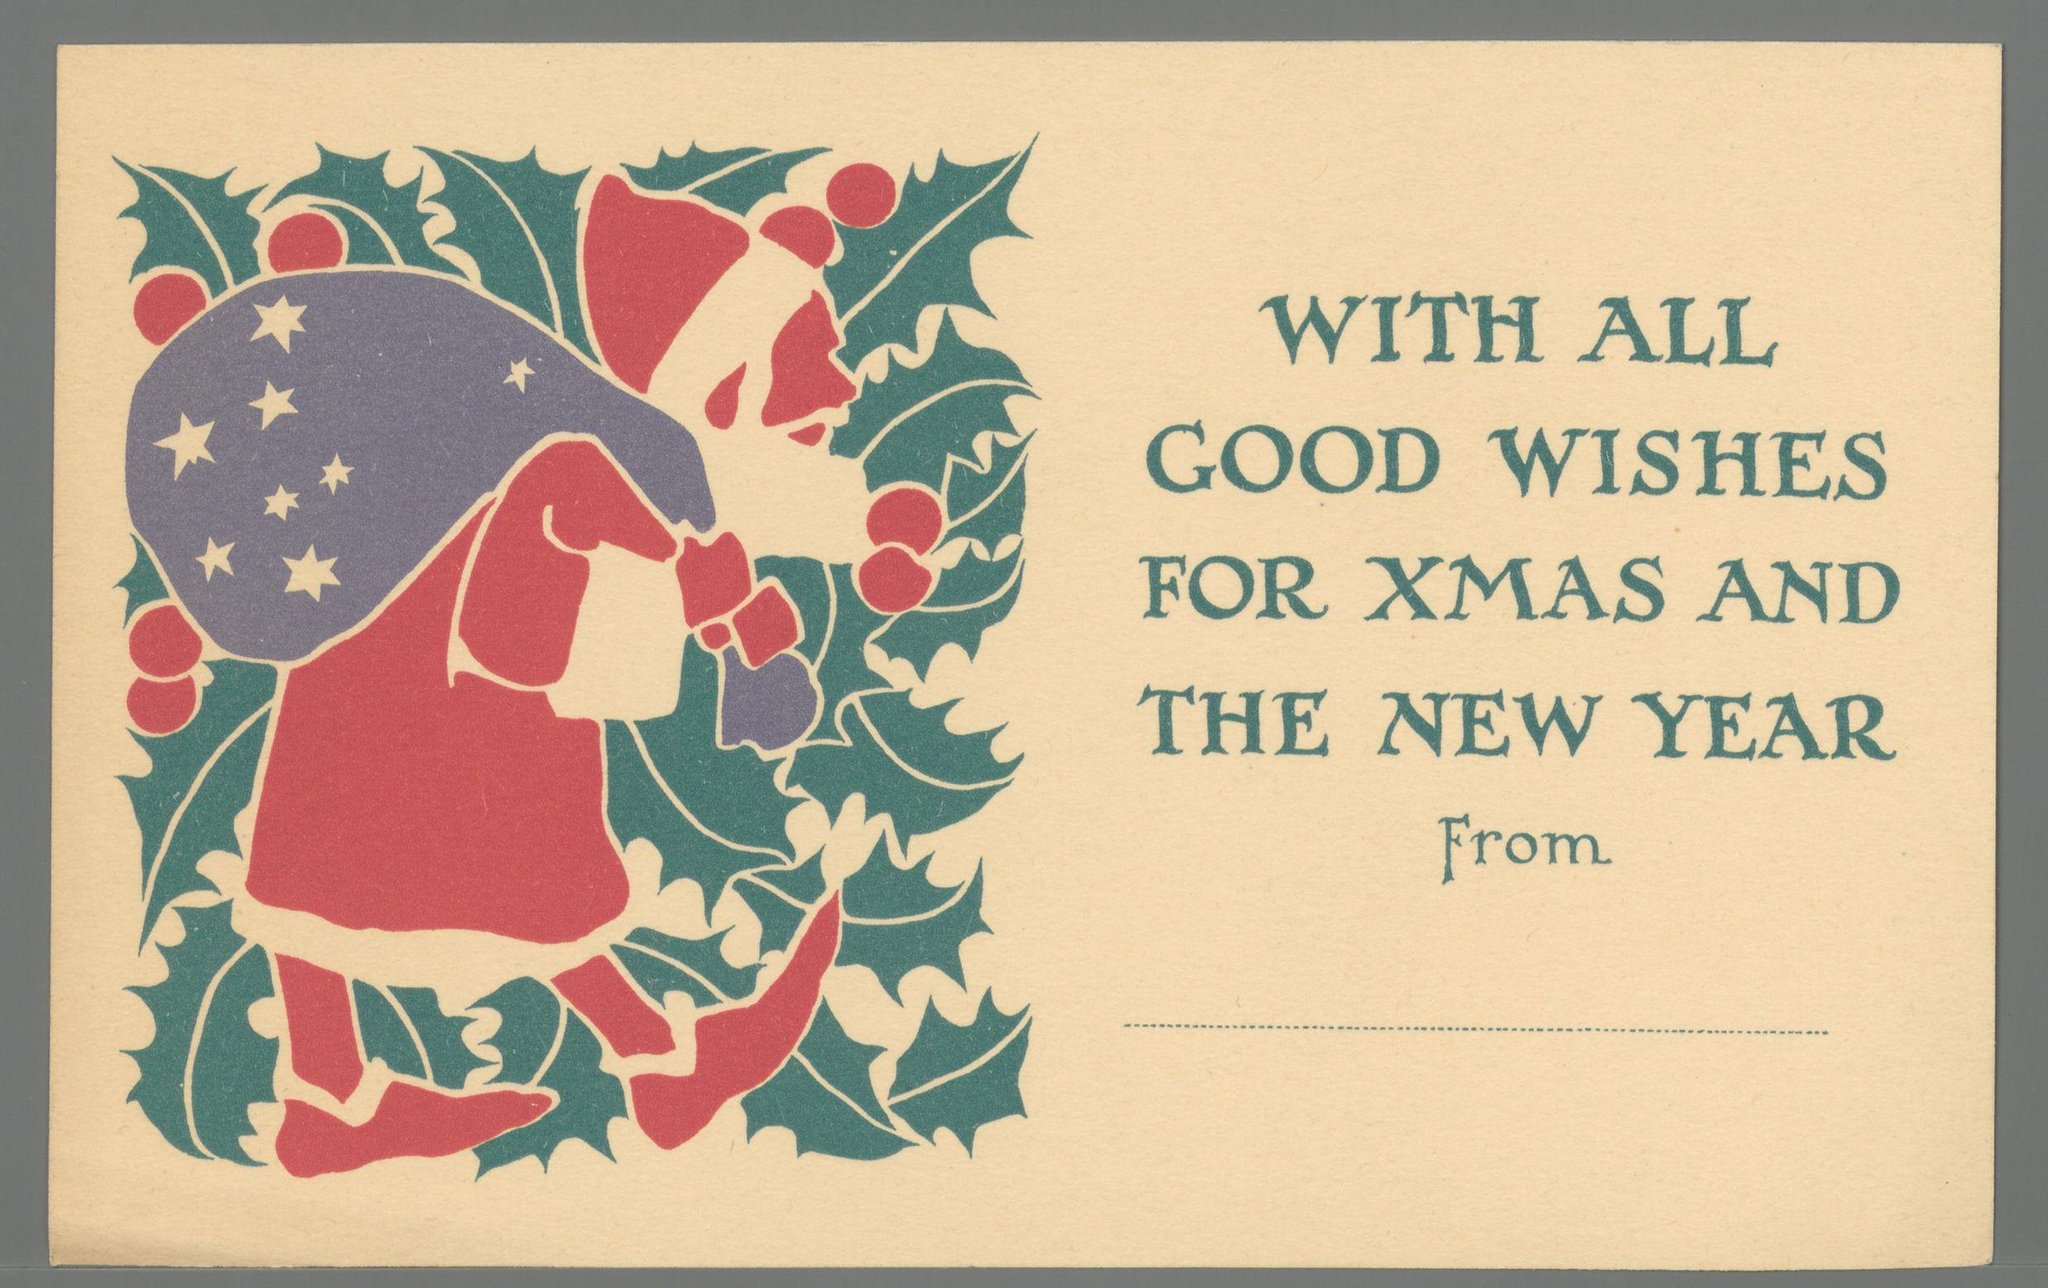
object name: ansichtkaart, prentbriefkaart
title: With All Good Wishes for XMas and the New Year from .....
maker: Anonymous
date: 1940-1960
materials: cardboard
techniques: lithograph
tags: plants and herbs: holly, father christmas, santa claus, christmas elf